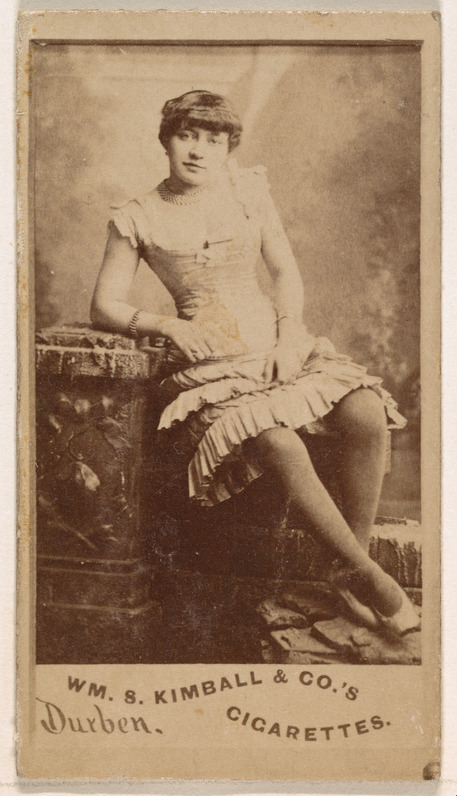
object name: photograph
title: Miss Durben, from the Actresses series (N203) issued by Wm. S. Kimball & Co.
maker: william s. kimball & company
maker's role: publisher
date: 1889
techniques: color lithograph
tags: portraits,women,actresses